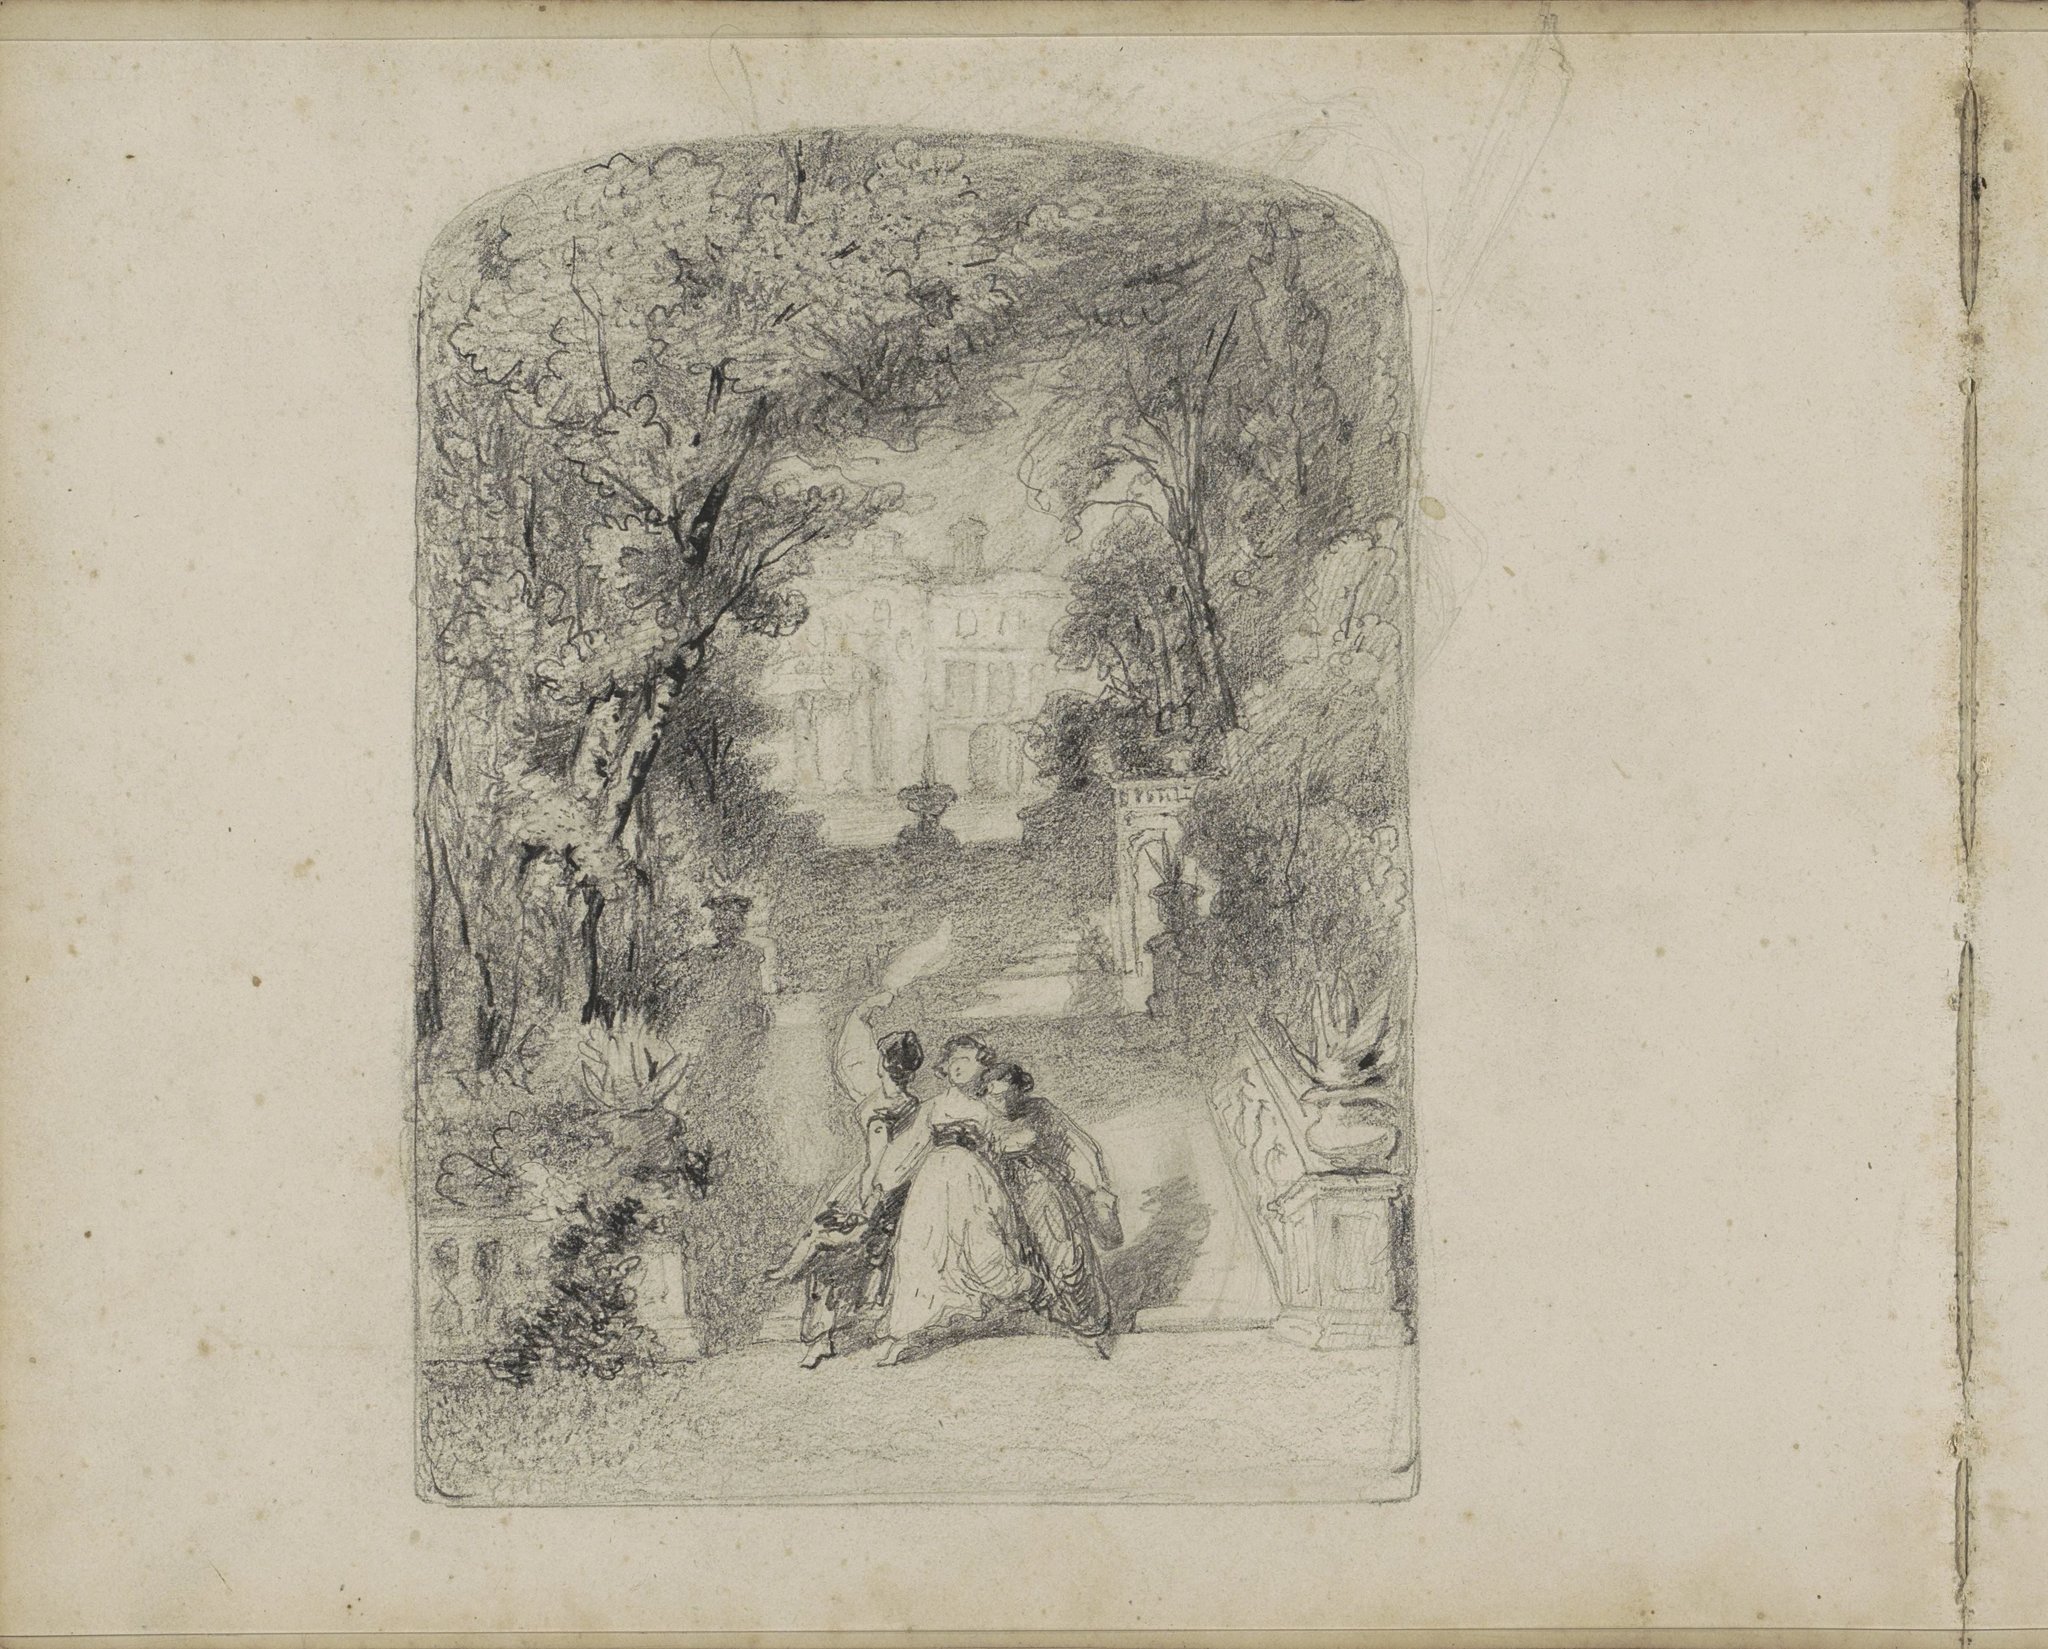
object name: sketchbook leaf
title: Drie vrouwen in een tuin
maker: gerrit postma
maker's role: draughtsman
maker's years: 1819-1894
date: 1829-1894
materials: paper, pencil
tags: garden, country-house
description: Vermoedelijk maakt de tuin deel uit van het landgoed van een villa, die op de achtergrond te zien is. Tekening in een kader. Blad 33 verso uit een schetsboek met 35 bladen.